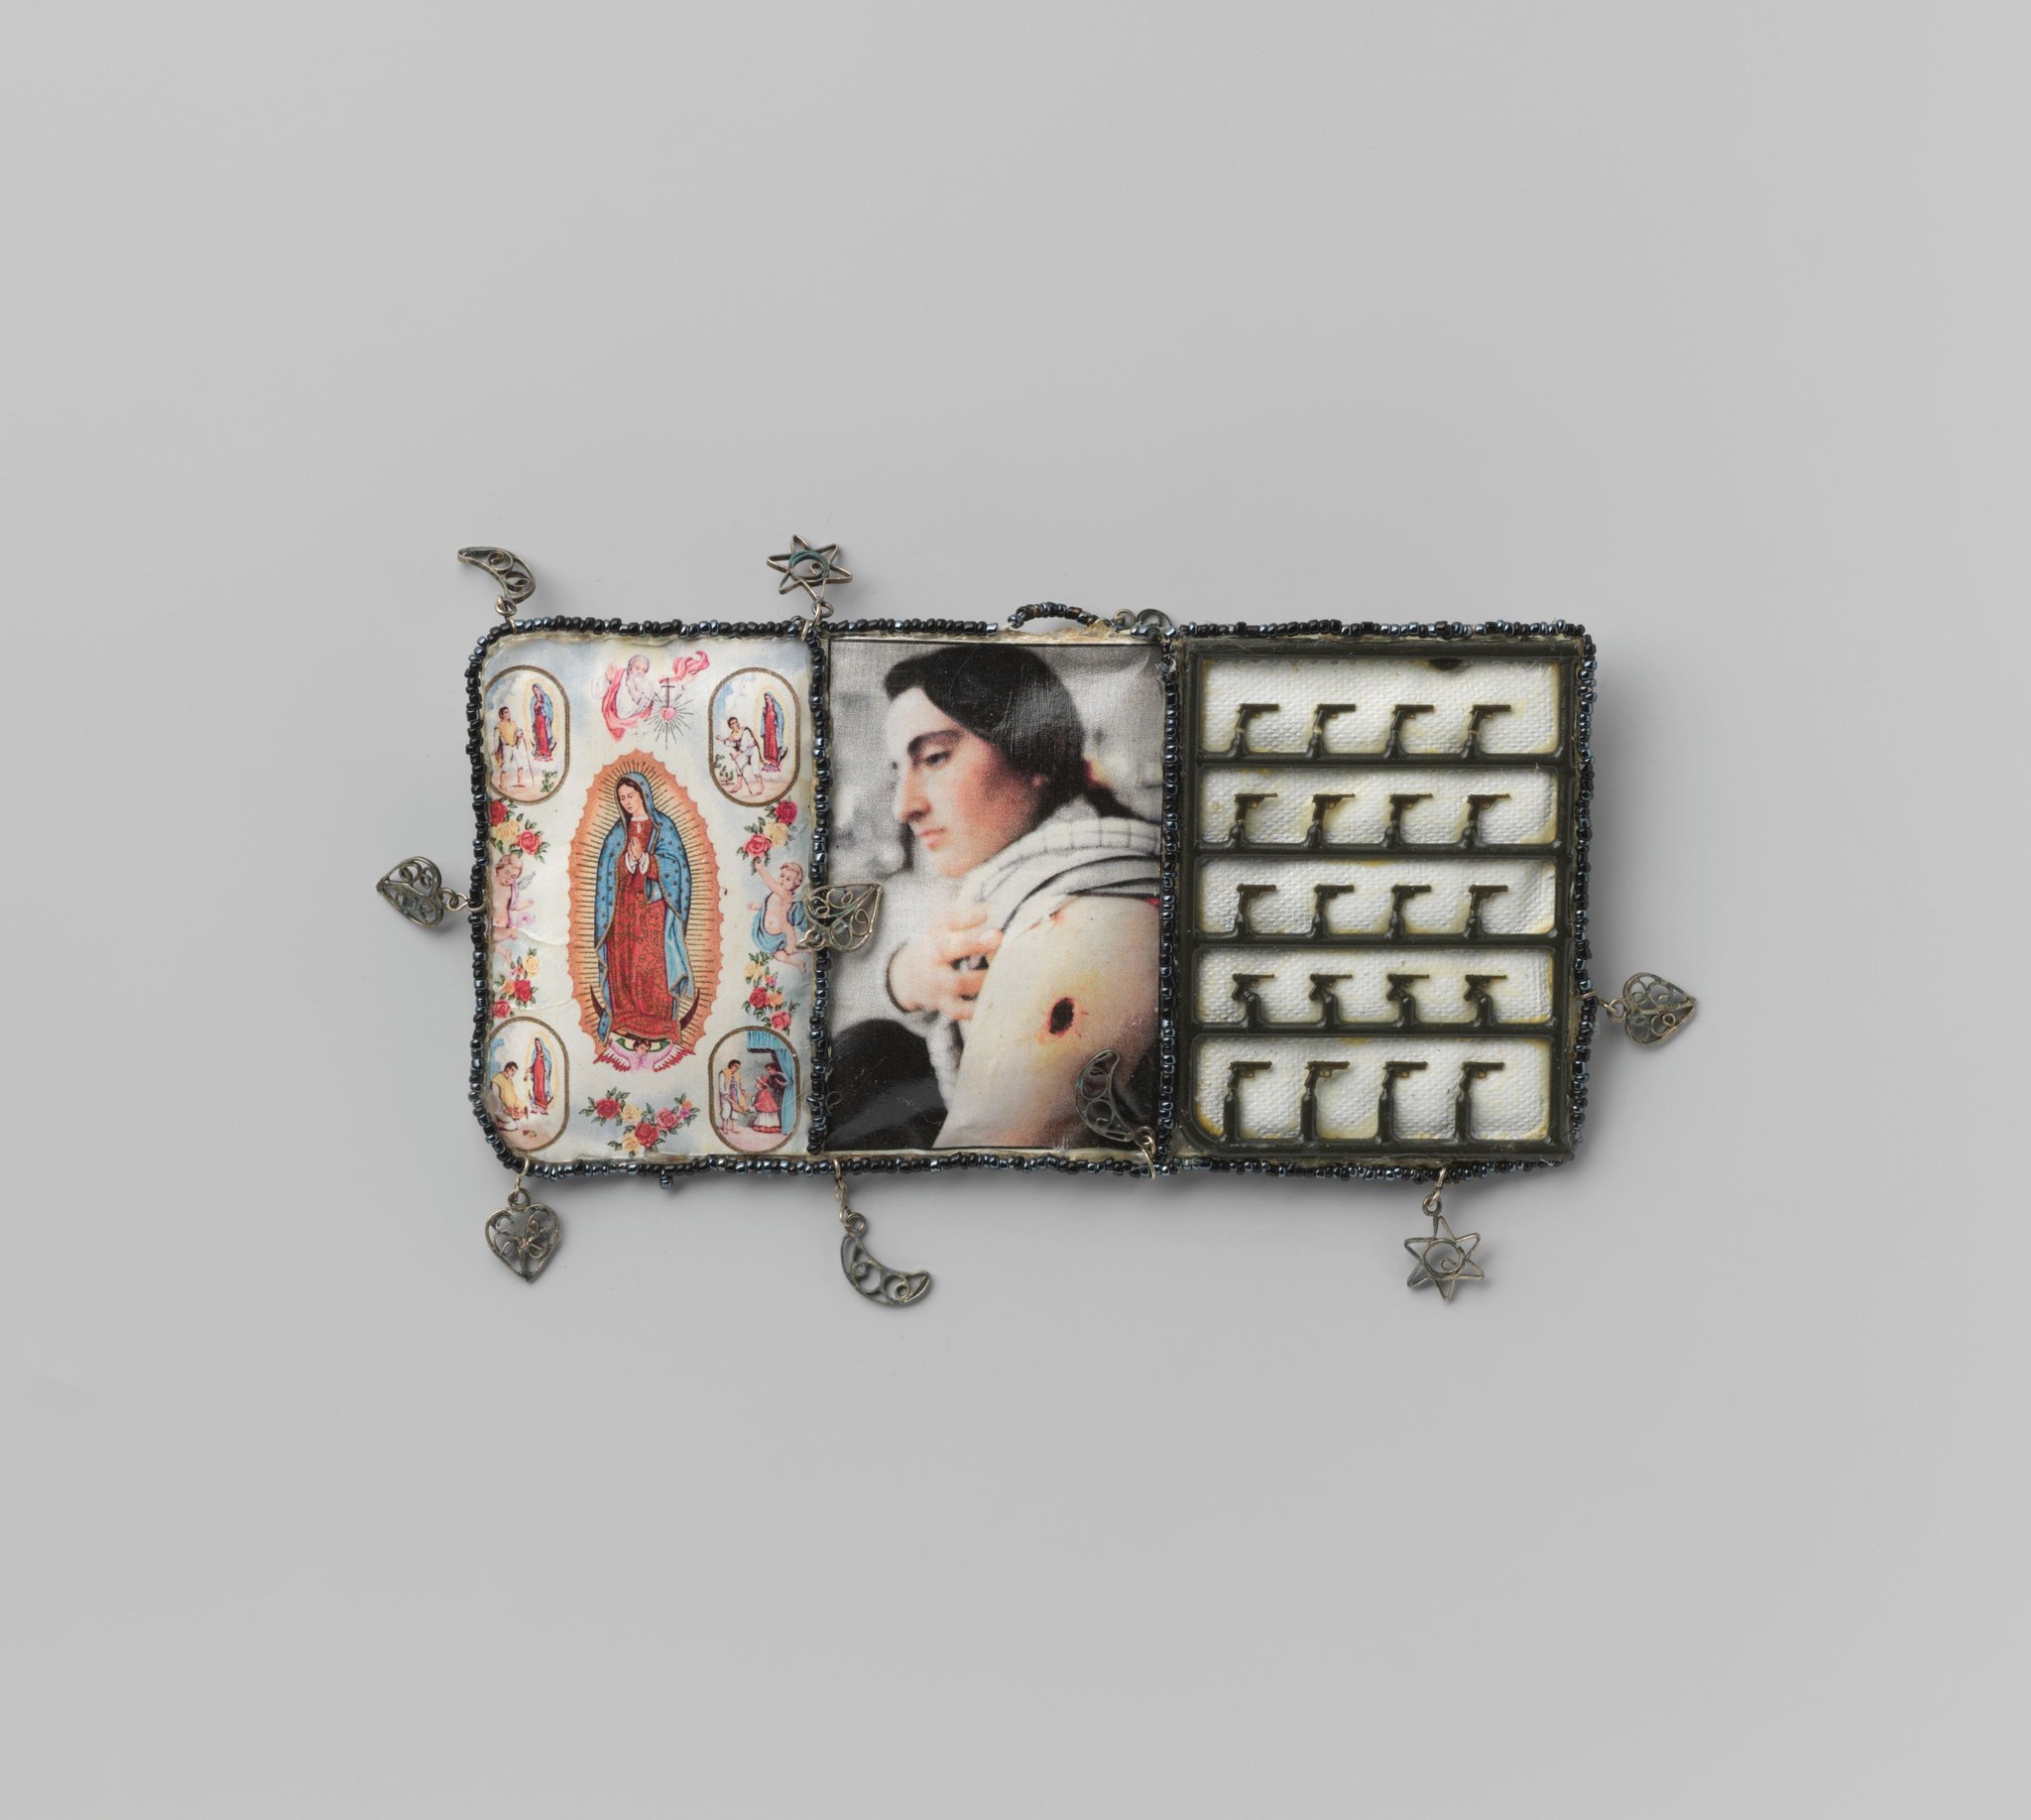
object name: brooch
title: Kosovo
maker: petra hartman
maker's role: designer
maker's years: 1960-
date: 1999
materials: cordage, metal, paper, plastic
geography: netherlands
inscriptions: signature: ‘Petra’